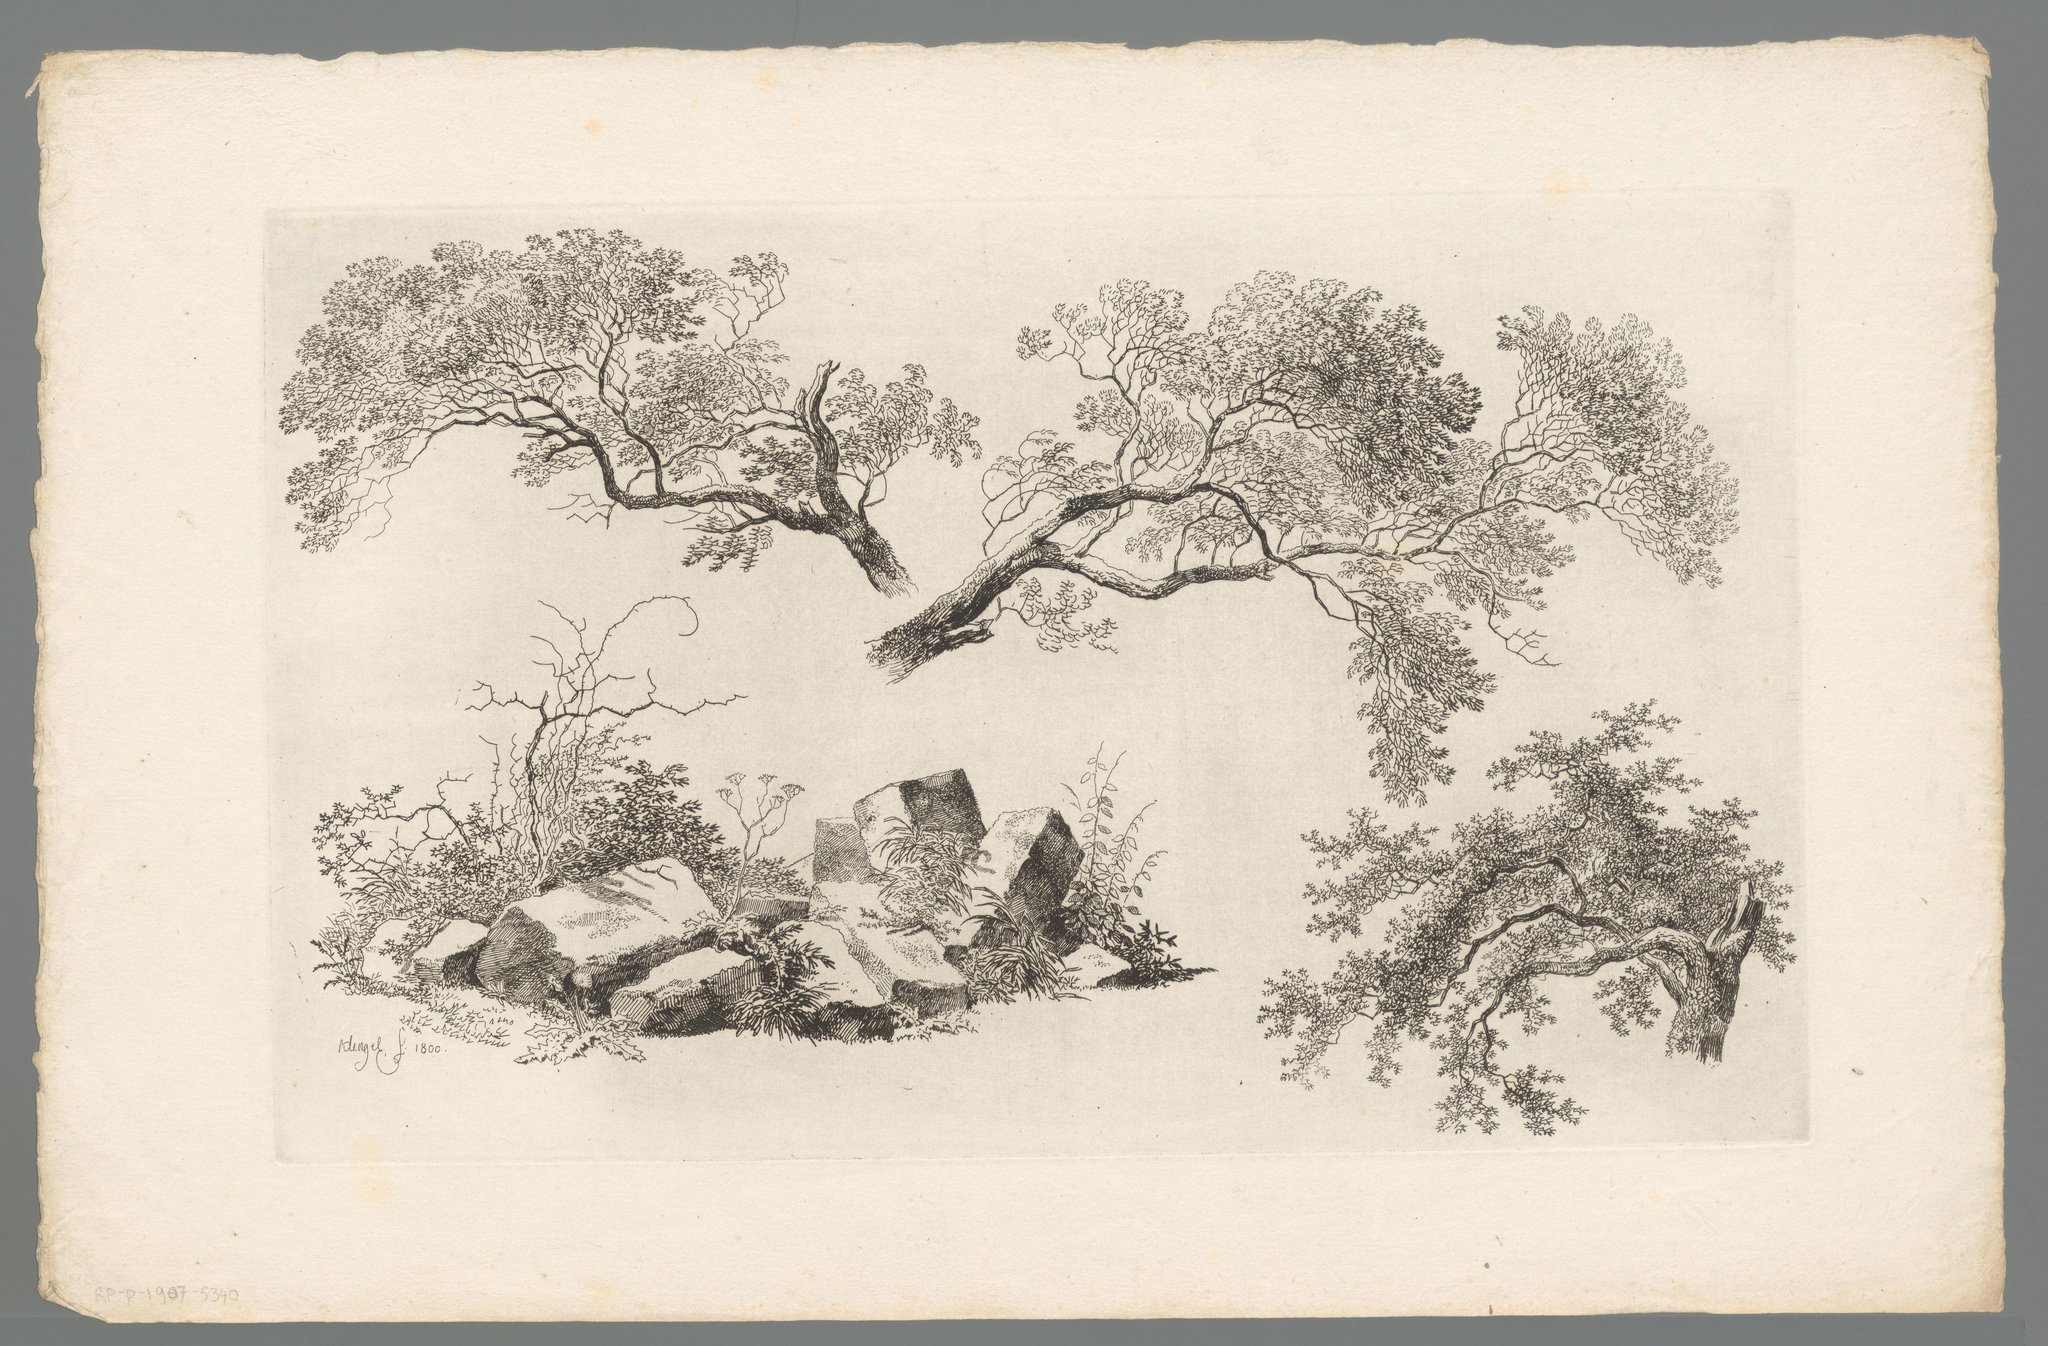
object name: print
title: Principes des Dessein pour les Paysages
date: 1800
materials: paper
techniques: etching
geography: dresden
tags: trees, shrubs, foliage, tendrils, branches ~ ornament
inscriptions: collector's mark: Lugt 2228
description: Prent hoort bij de uitgave: Klengel, Johann Christian. Principes de Dessein pour Les Paysages par J.C. Klengel, professeur de l'Academie Electorale de Peinture a Dresde. Se vend chez Henry Rittner au Magazin des Beaux Arts Rue de Chateau no. 329 a Dresde. Dresden: Heinrich Rittner, 1802.